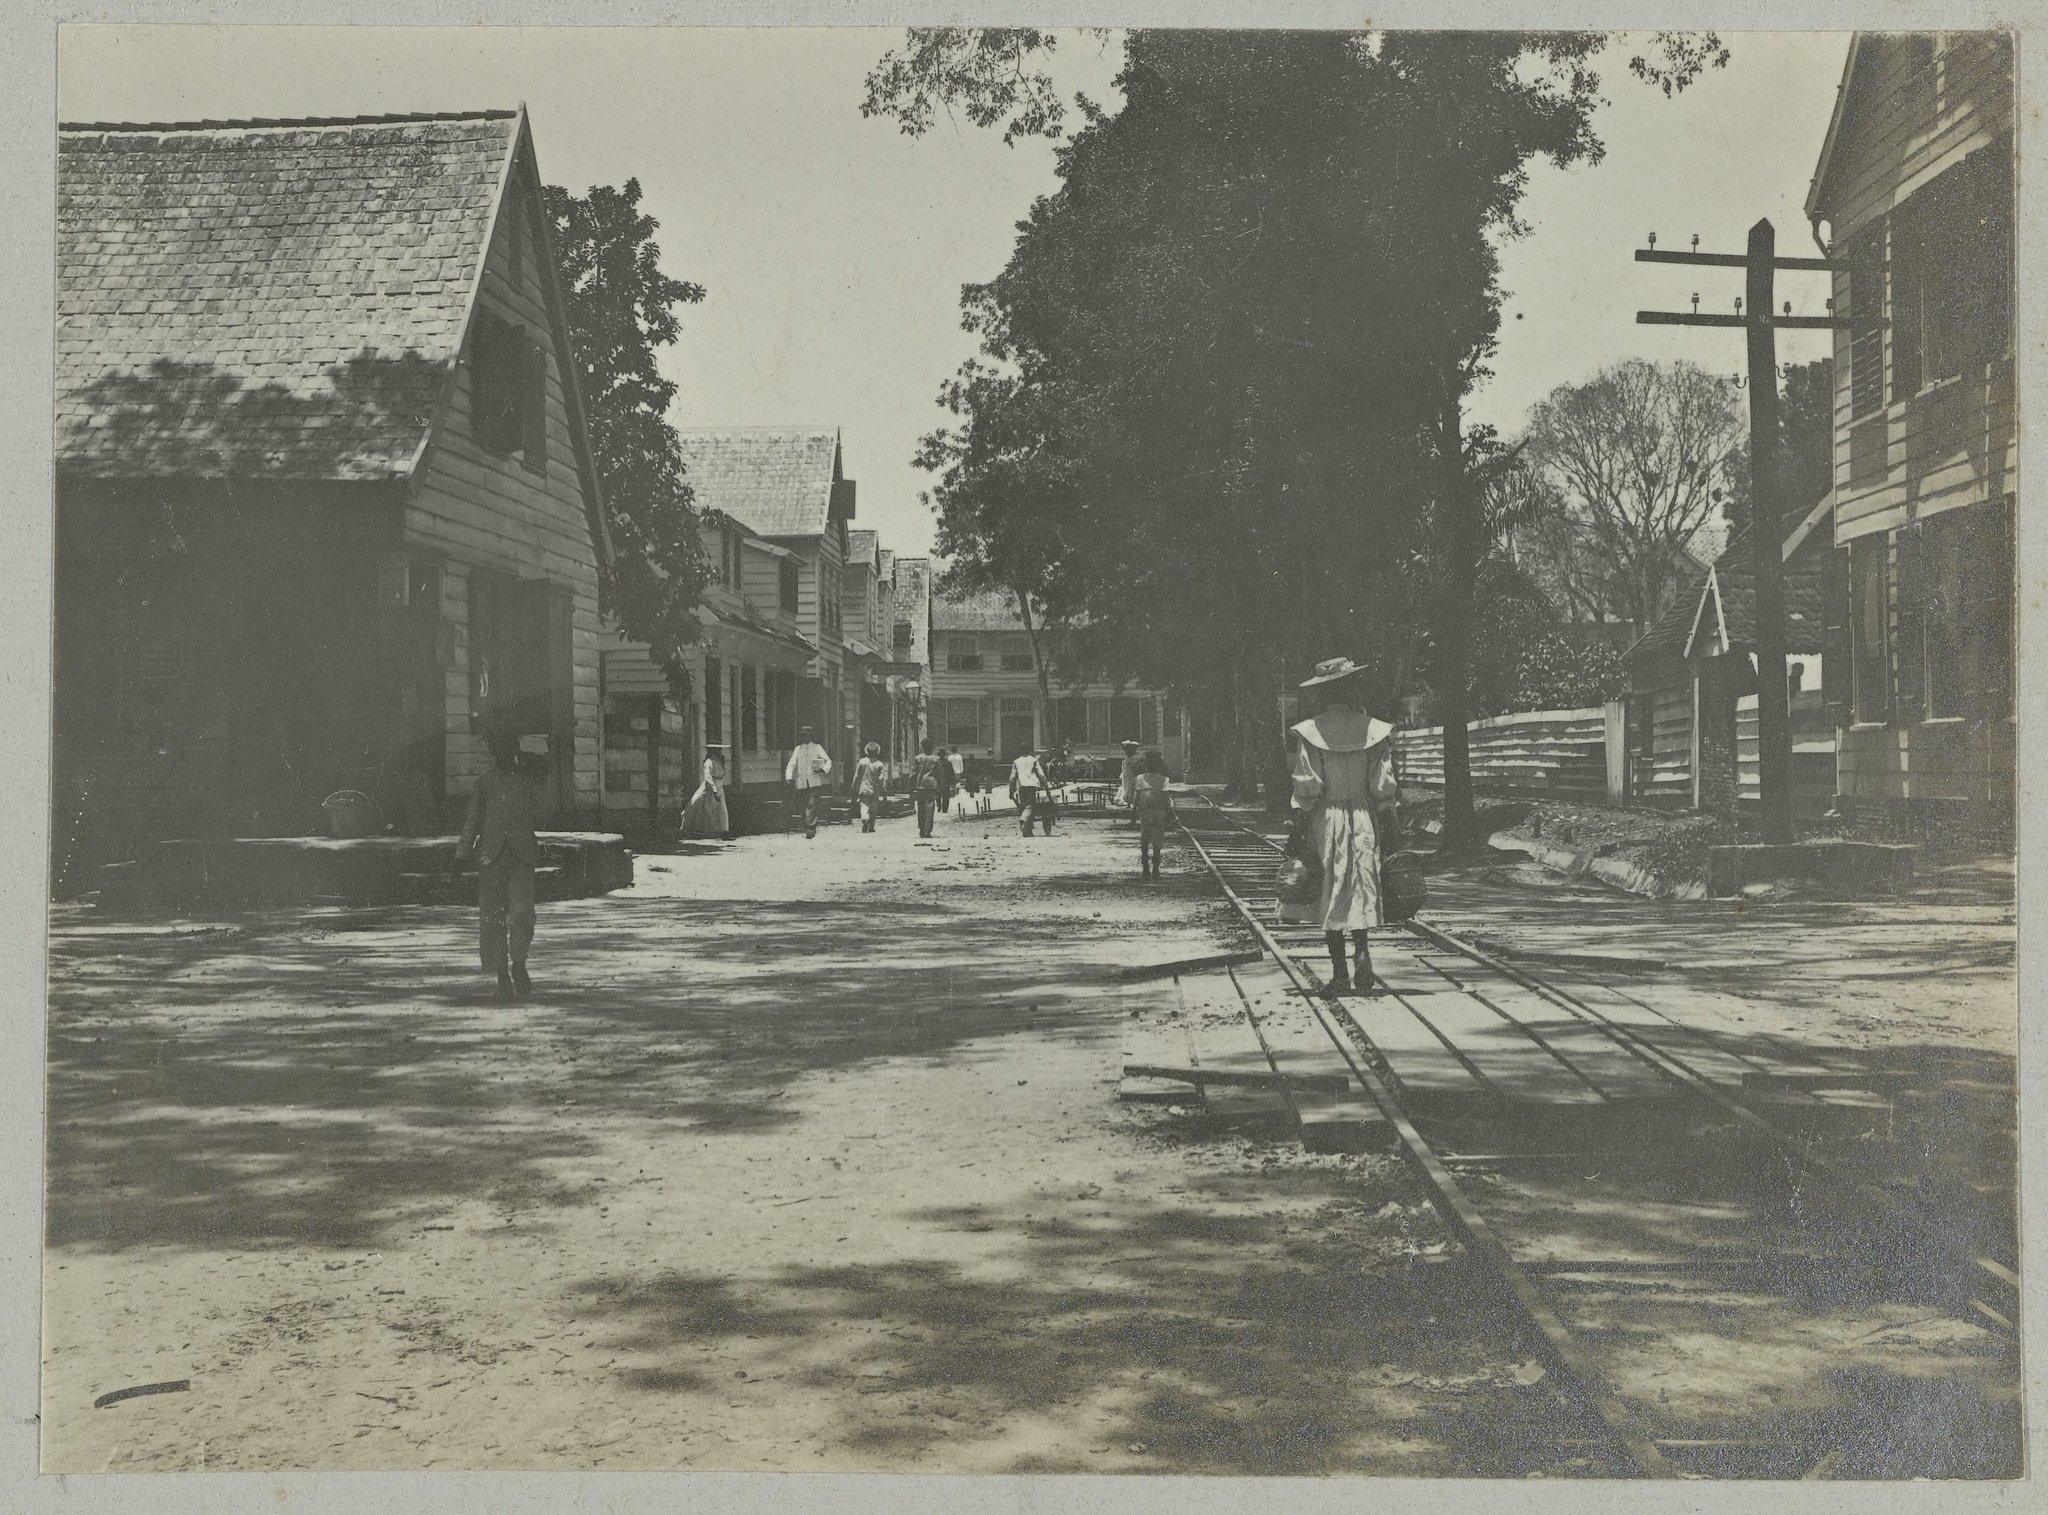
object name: photograph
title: Klipsteenstraat en Emmaschool, Paramaribo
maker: hendrik doijer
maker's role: engineer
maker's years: 1863-1925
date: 1903-1910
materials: photographic support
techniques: gelatin silver print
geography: suriname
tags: suriname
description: Gezicht in de Klipsteenstraat met schoolgaande kinderen op weg naar de Emmaschool te Paramaribo. Onderdeel van het fotoalbum Souvenir de Voyage (deel 1), over het leven van de familie Doijer in en rond de plantage Ma Retraite in Suriname in de jaren 1903-1910.